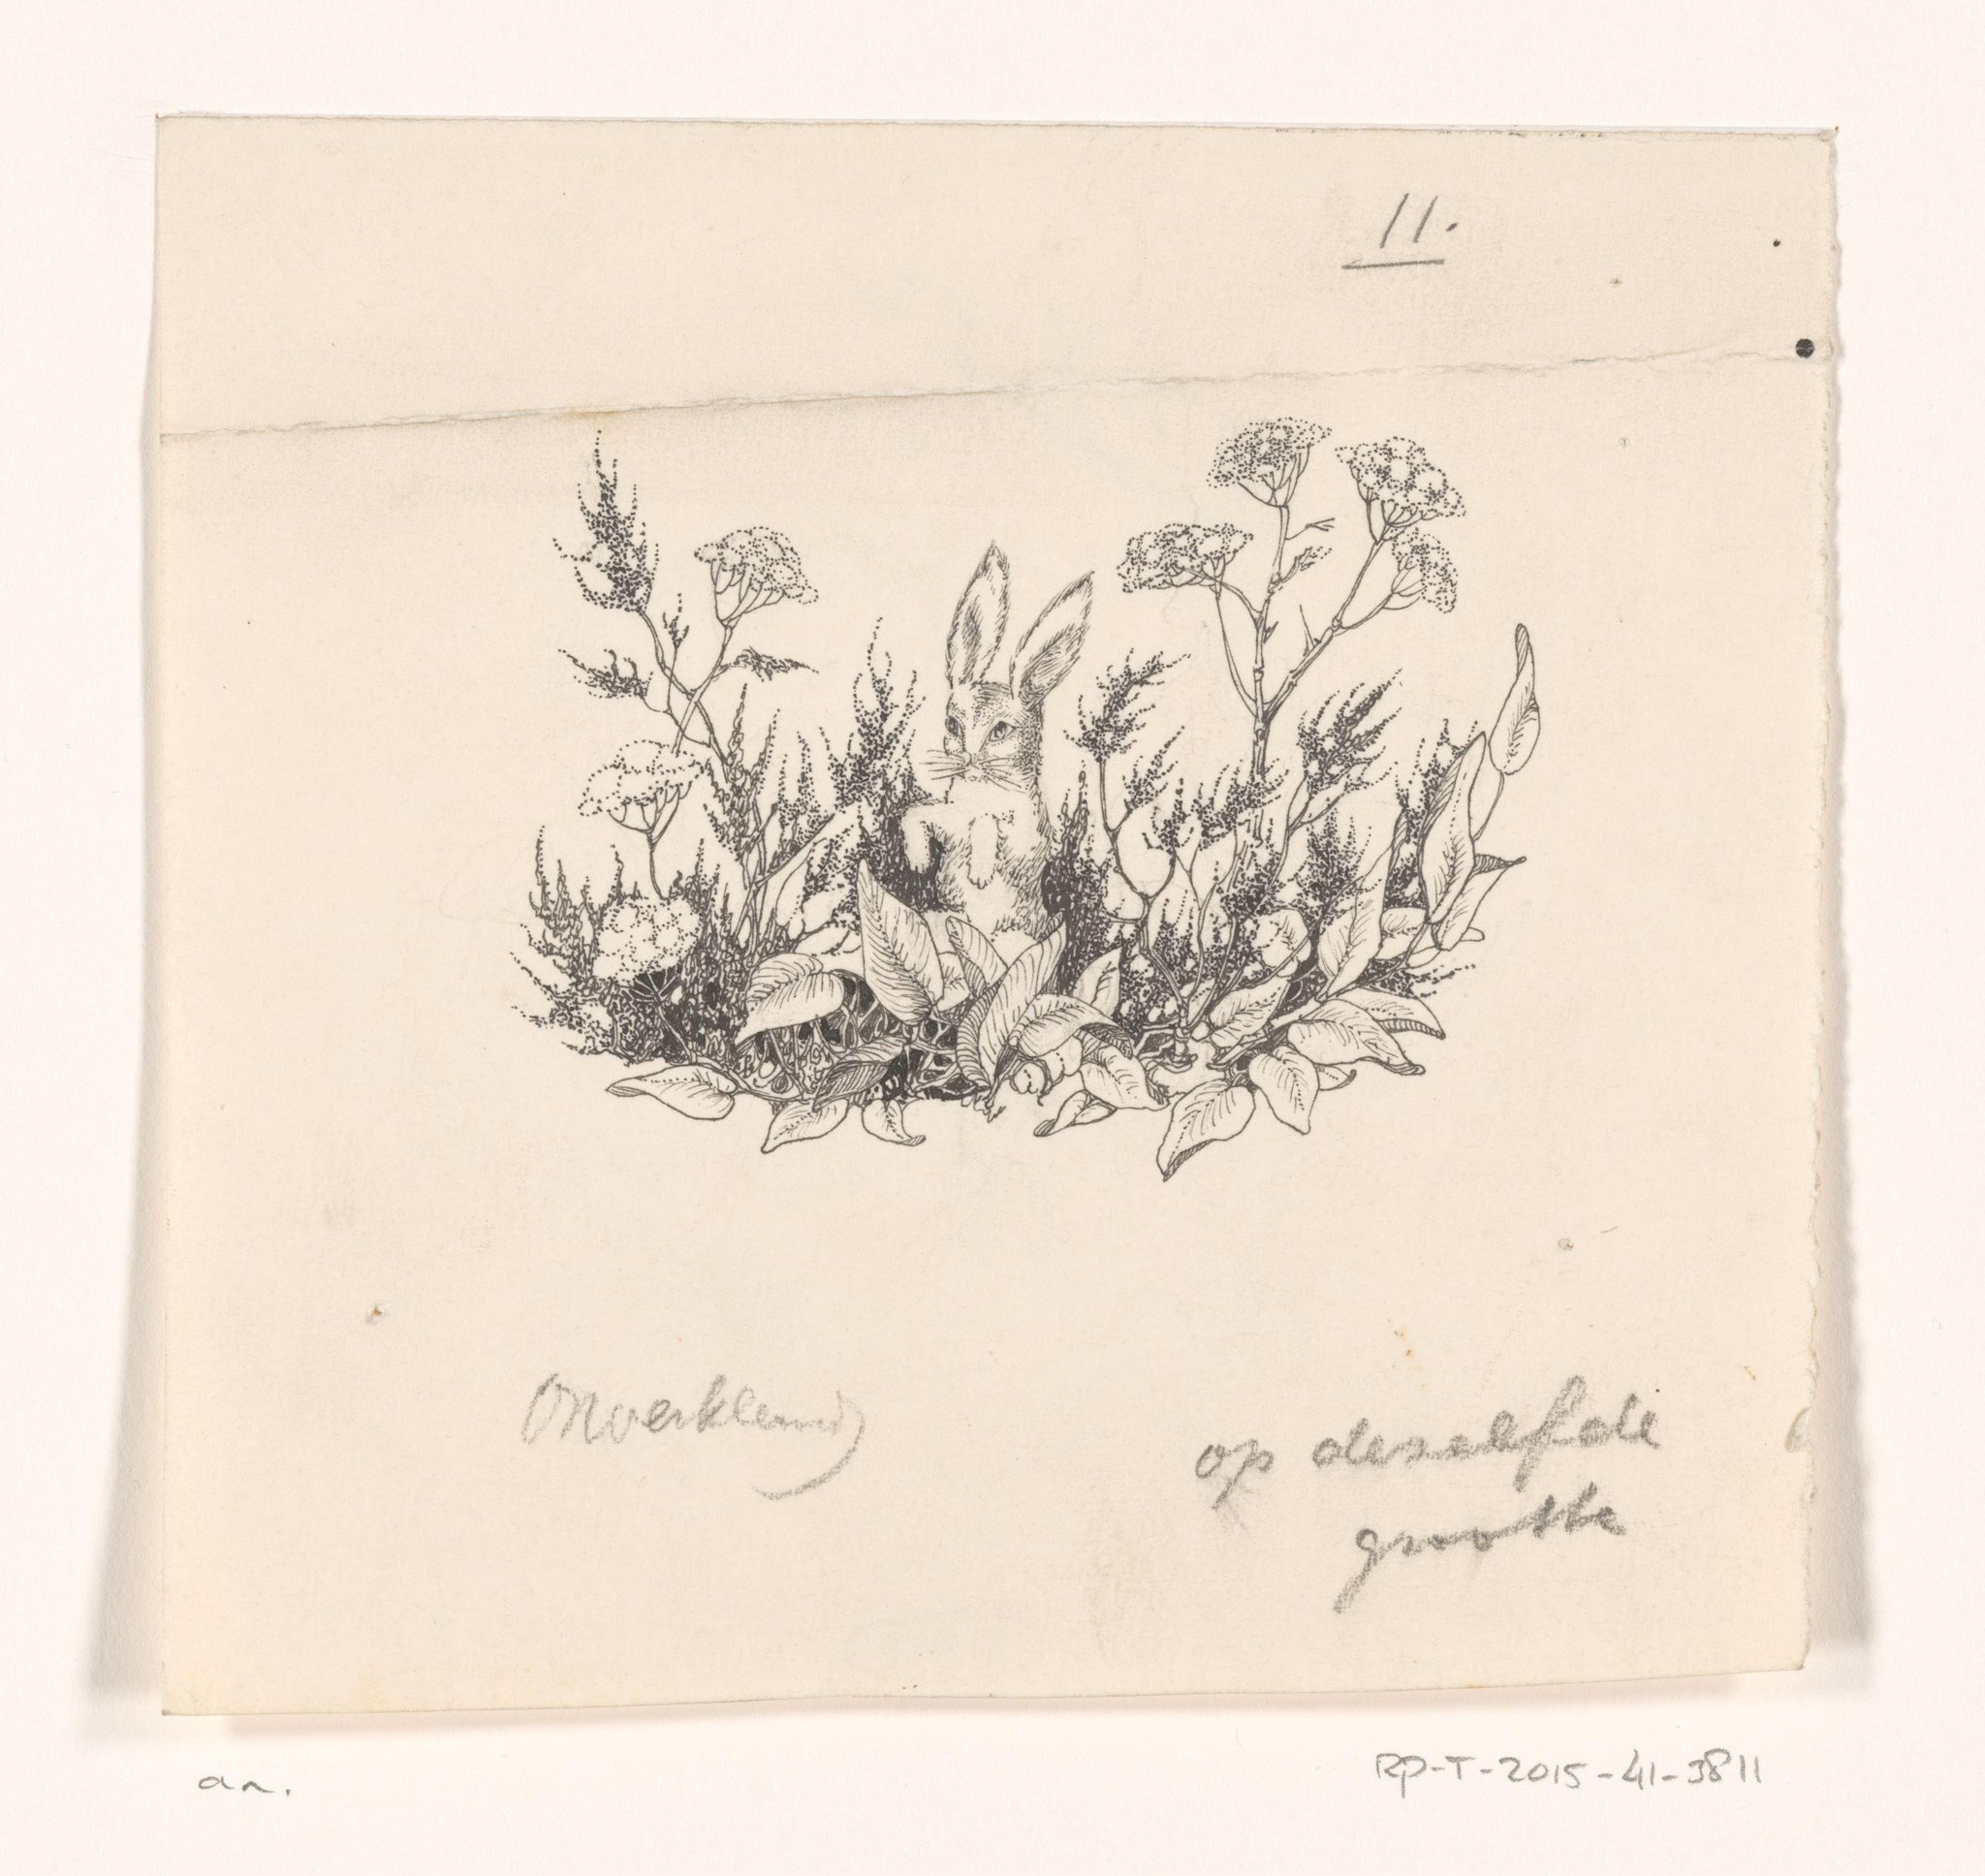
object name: boekillustratie ontwerp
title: Haas tussen bloemen en planten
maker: Anonymous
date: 1890-1930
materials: ink, paper, pencil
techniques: pen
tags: plants; vegetation, rodents: hare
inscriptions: number: ‘11.’, :, collector's mark: Lugt 2228a